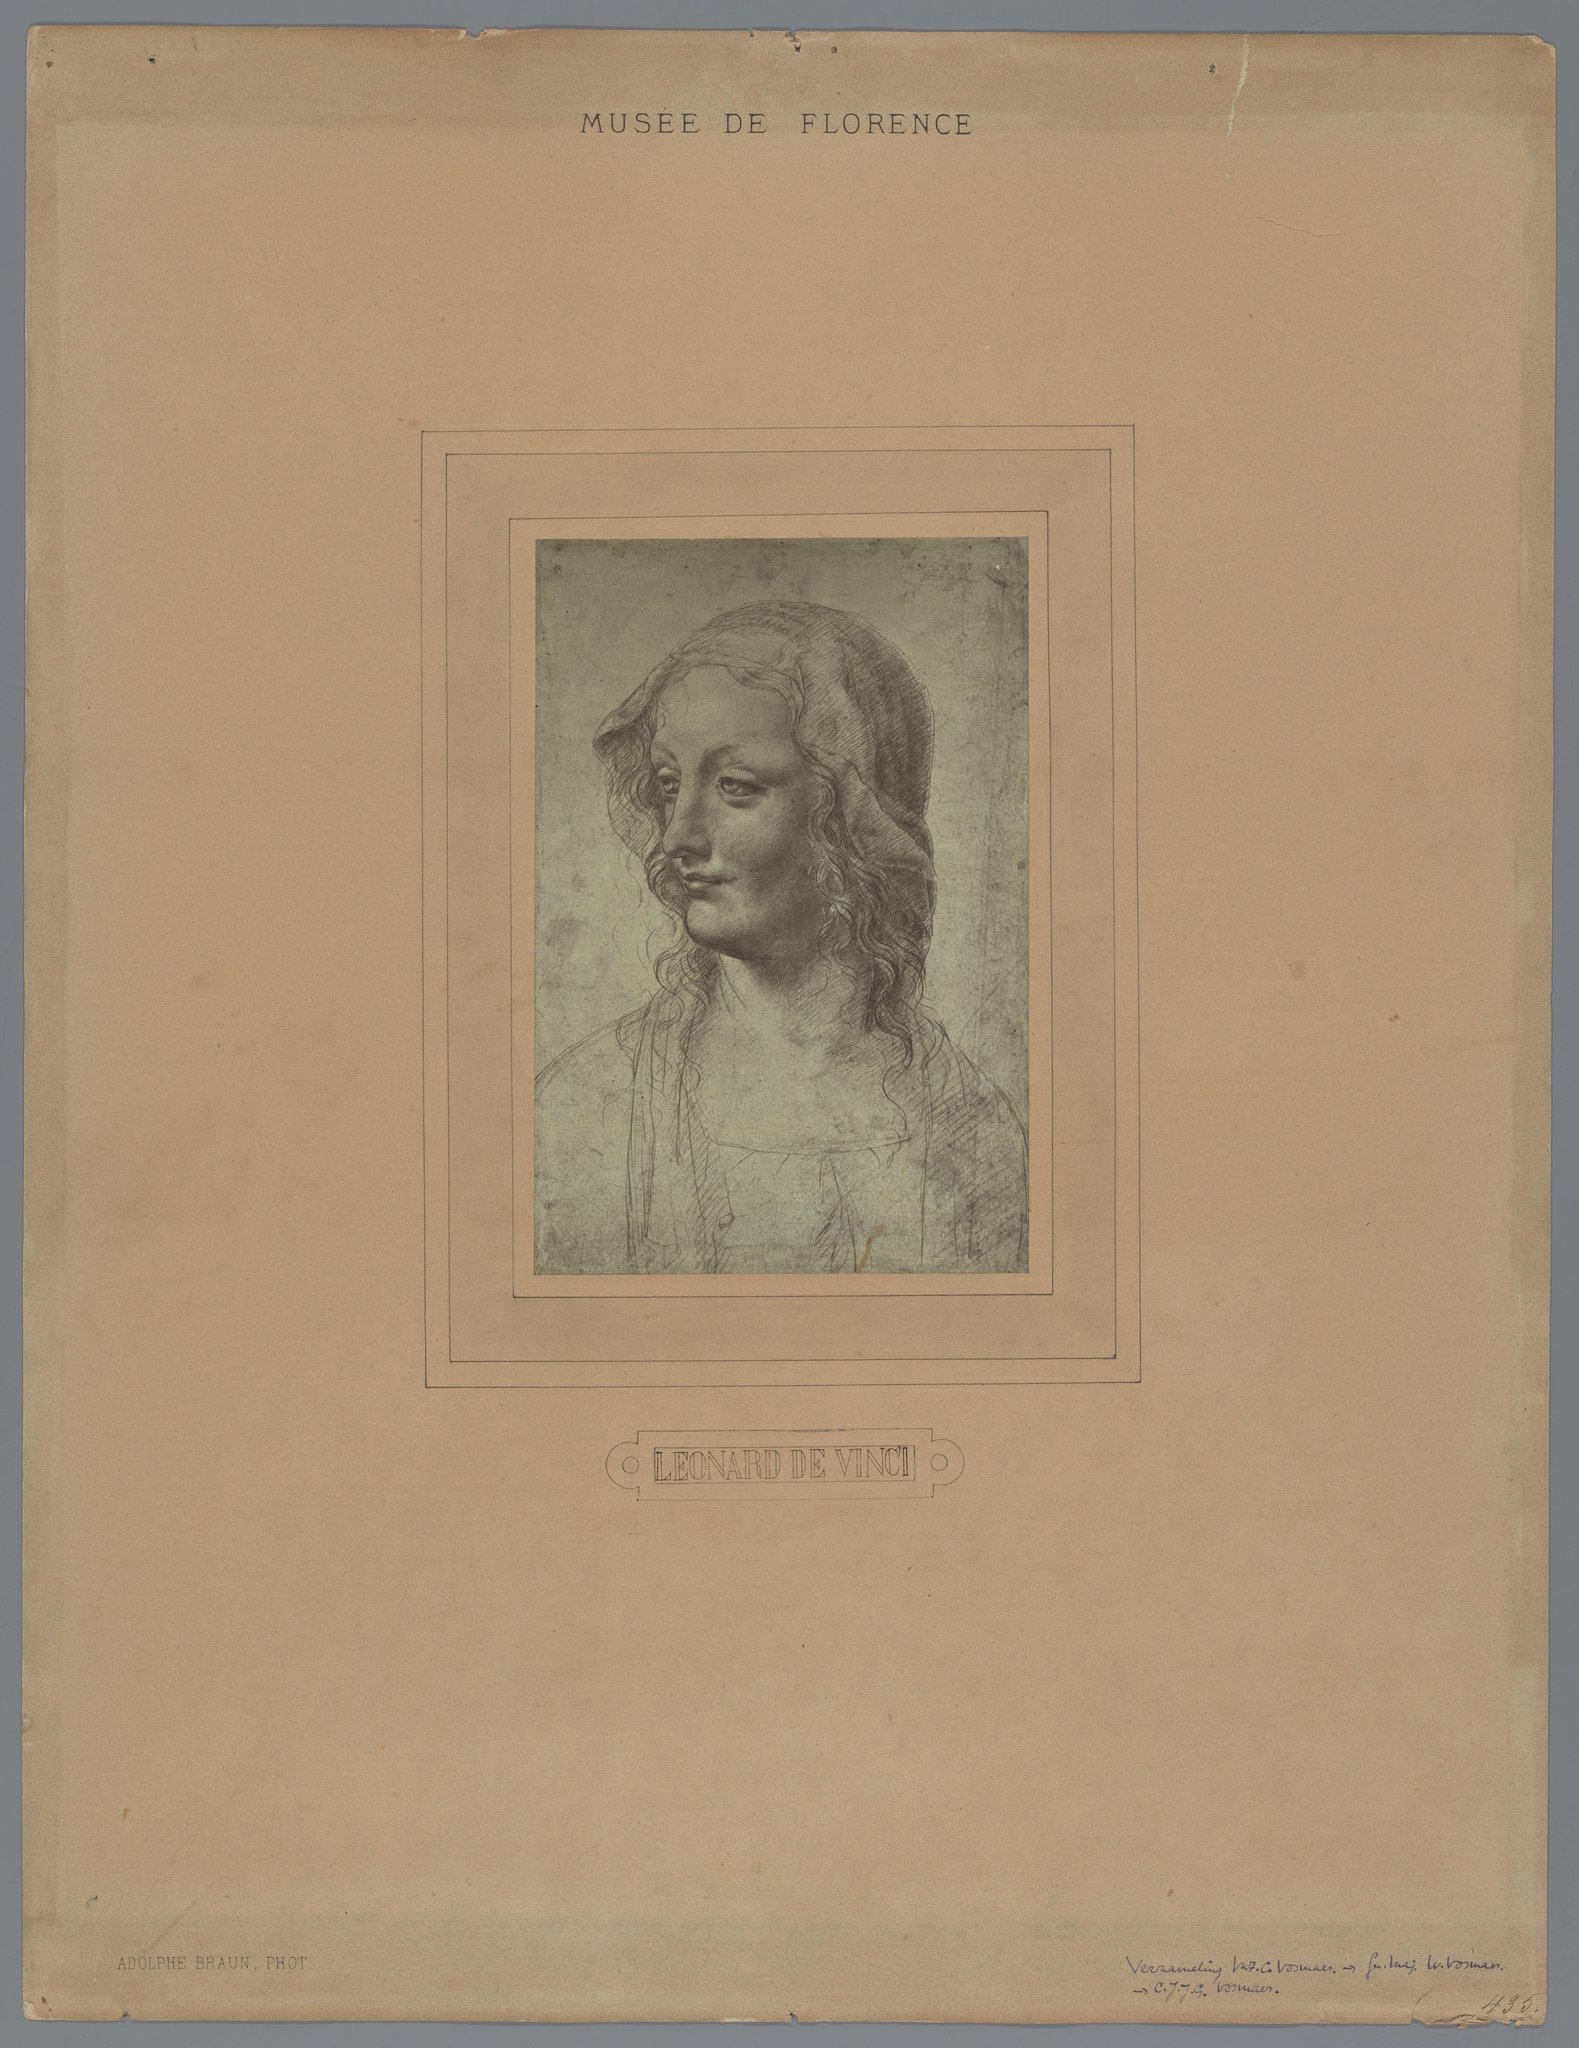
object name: photograph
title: Fotoreproductie van een tekening van Leonardo da Vinci (kop van een vrouw)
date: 1880-1900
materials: cardboard, paper, photographic support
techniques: carbon print